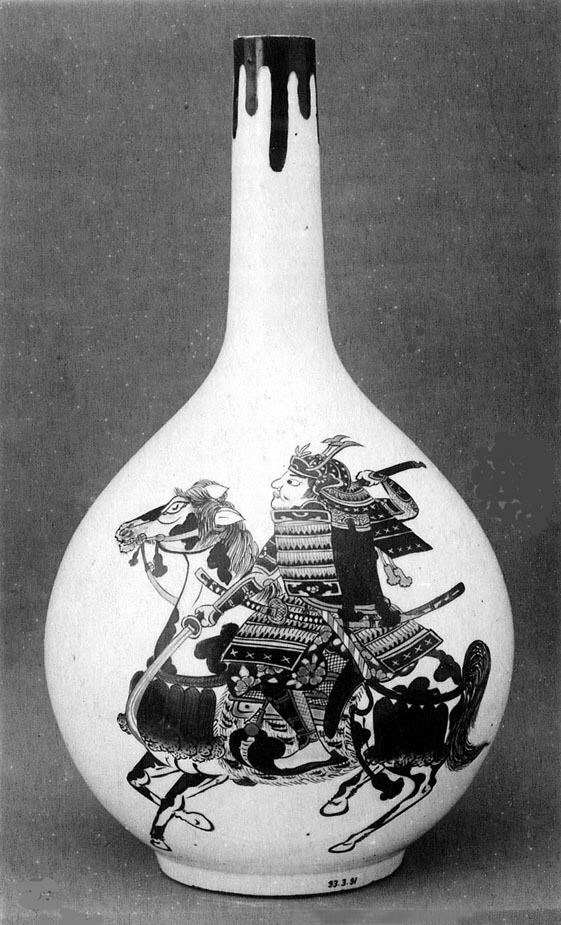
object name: bottle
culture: japanese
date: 1700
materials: enamel, porcelain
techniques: polychrome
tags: horses